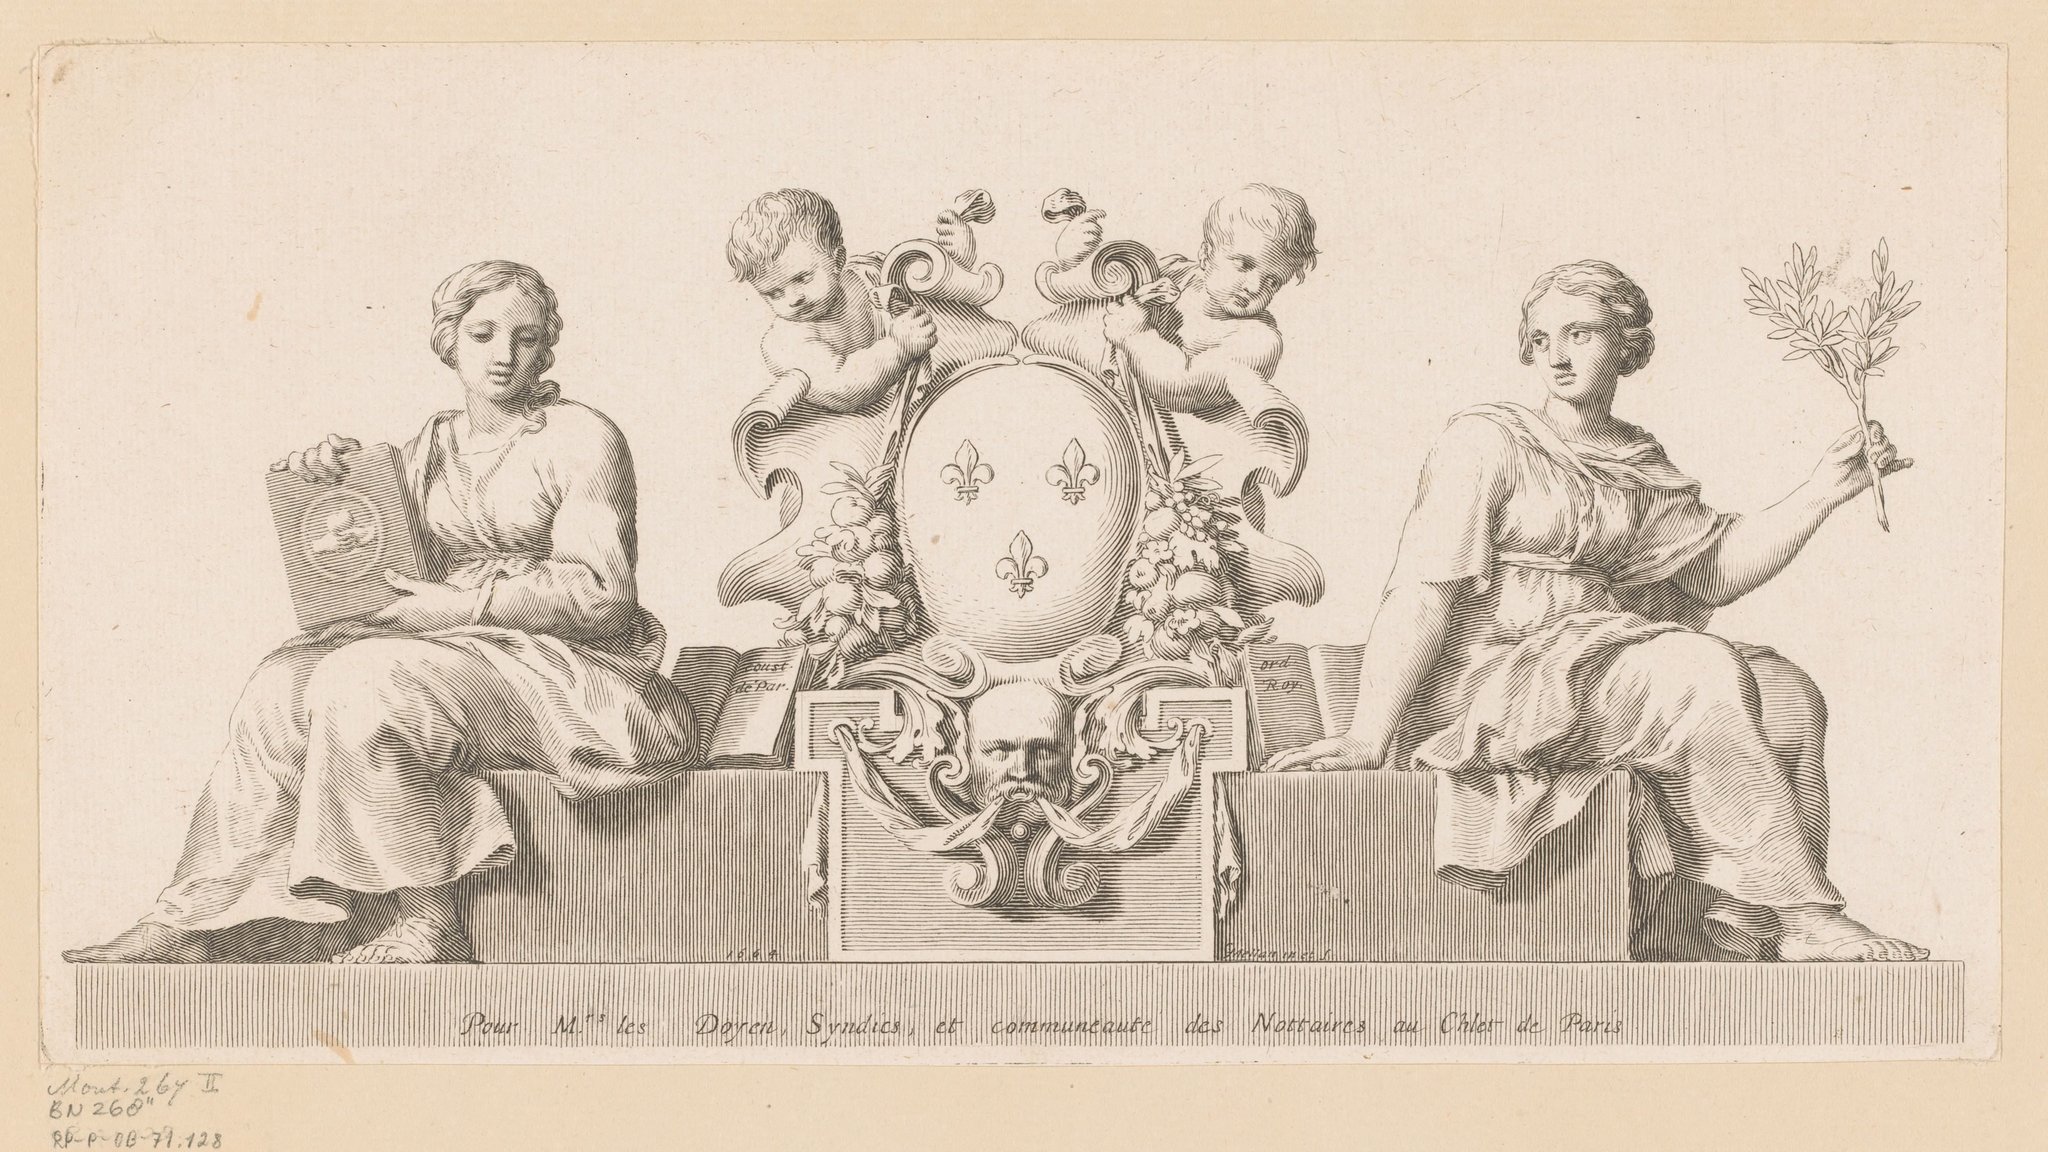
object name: print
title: Wapen van de notarissen van het Châtelet in Parijs met personificaties van het Goede Geloof en de Wet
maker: claude mellan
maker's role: draughtsman, print maker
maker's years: 1598-1688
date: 1664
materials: paper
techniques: engraving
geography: france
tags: armorial bearing, heraldry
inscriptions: collector's mark: Lugt 240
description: Deze prent is opgedragen aan de decanen, syndici en communautairen van de notarissen van het Châtelet in Parijs.